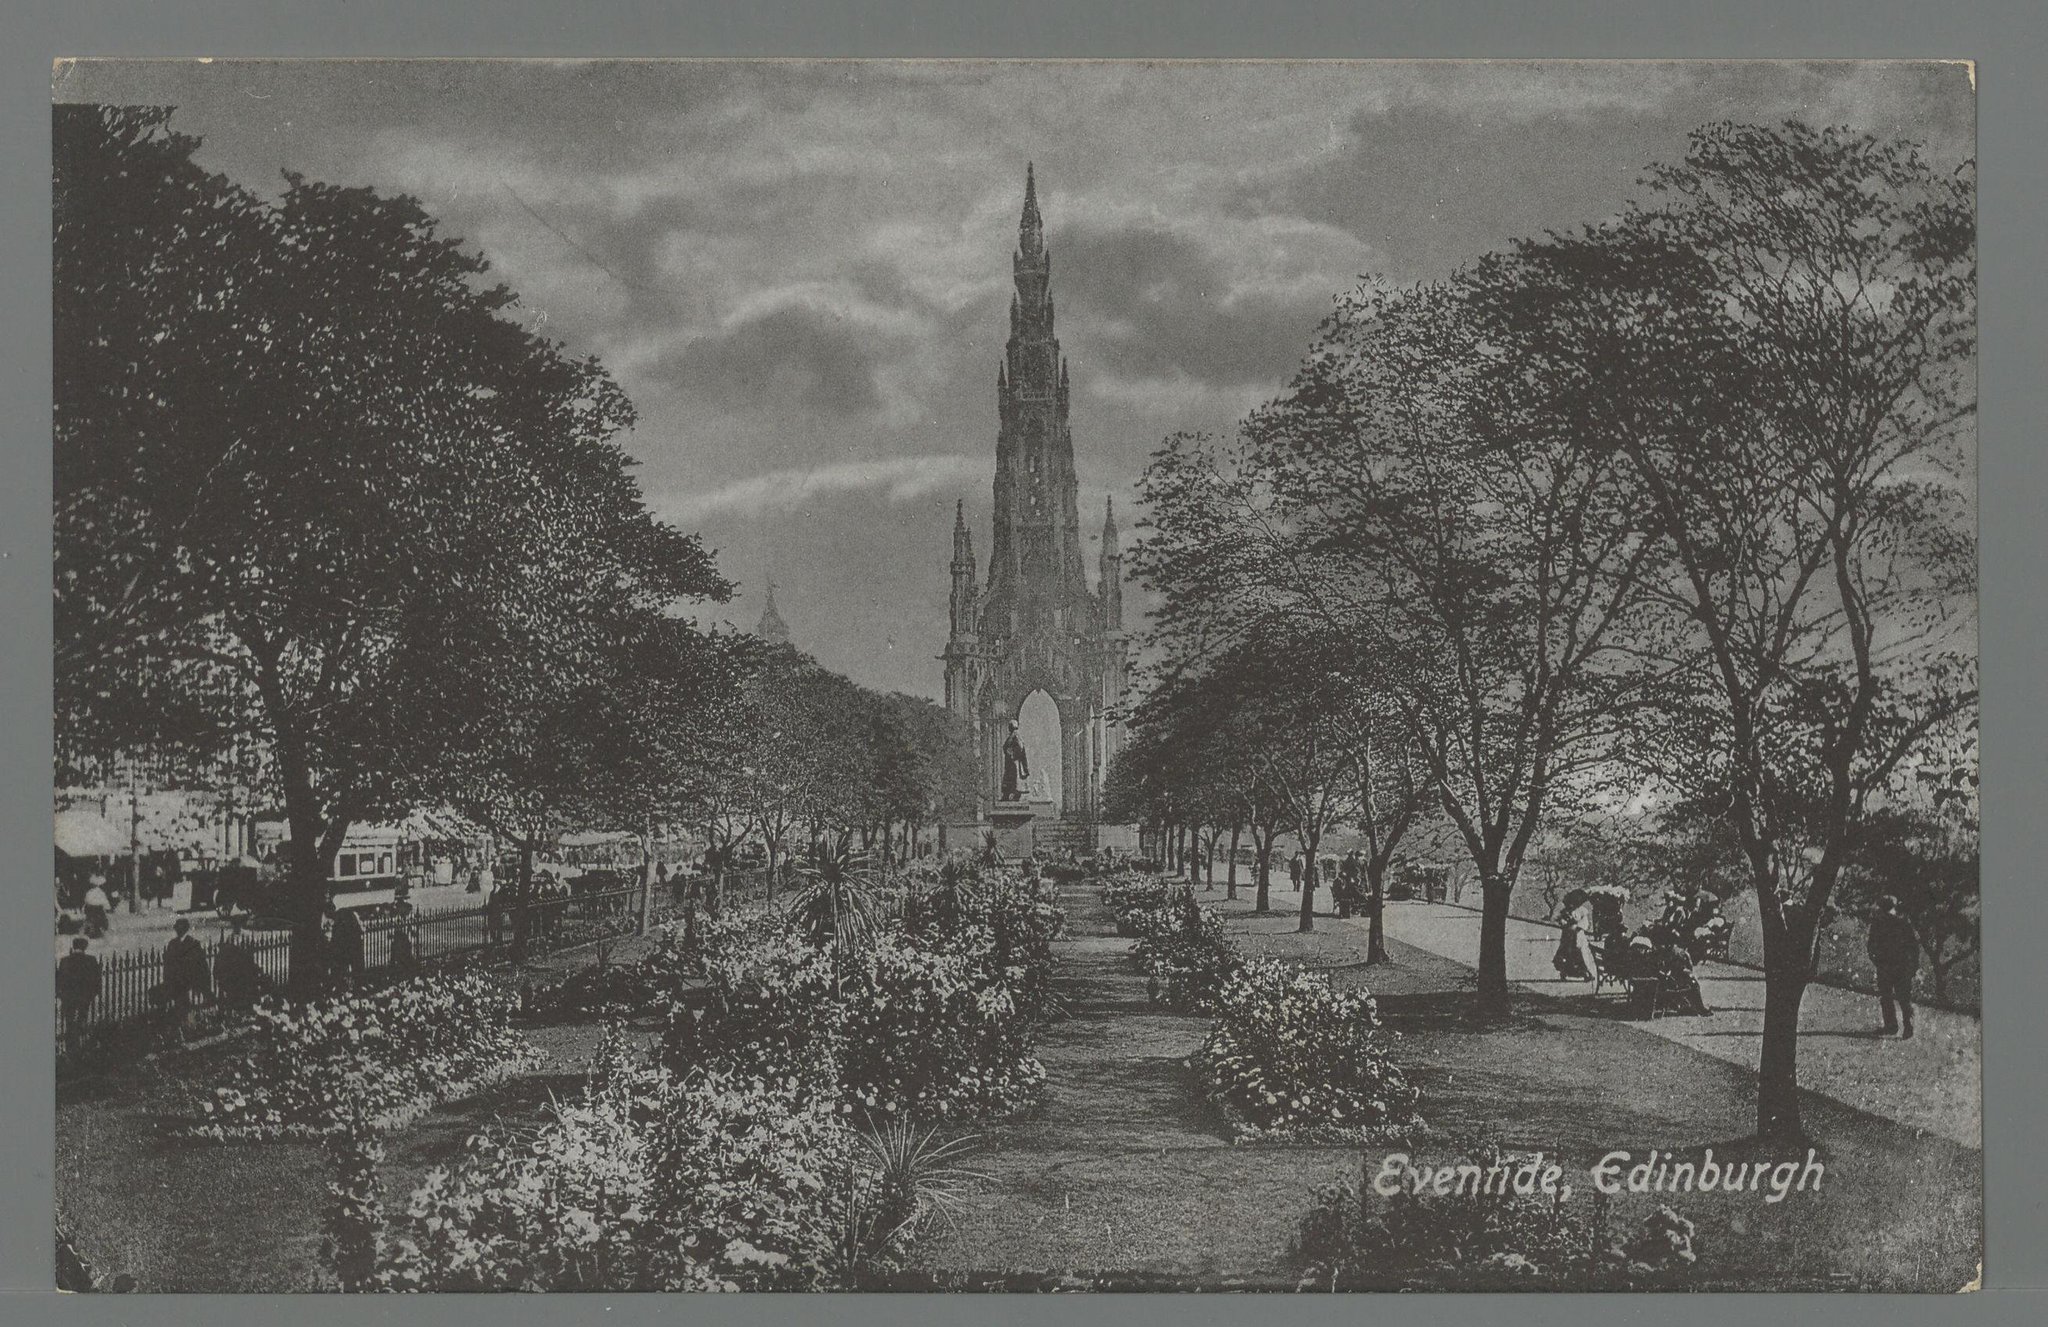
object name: ansichtkaart, prentbriefkaart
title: Eventide, Edinburgh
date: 1902-1930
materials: cardboard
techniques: photograph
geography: dundee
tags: garden, monument, statue